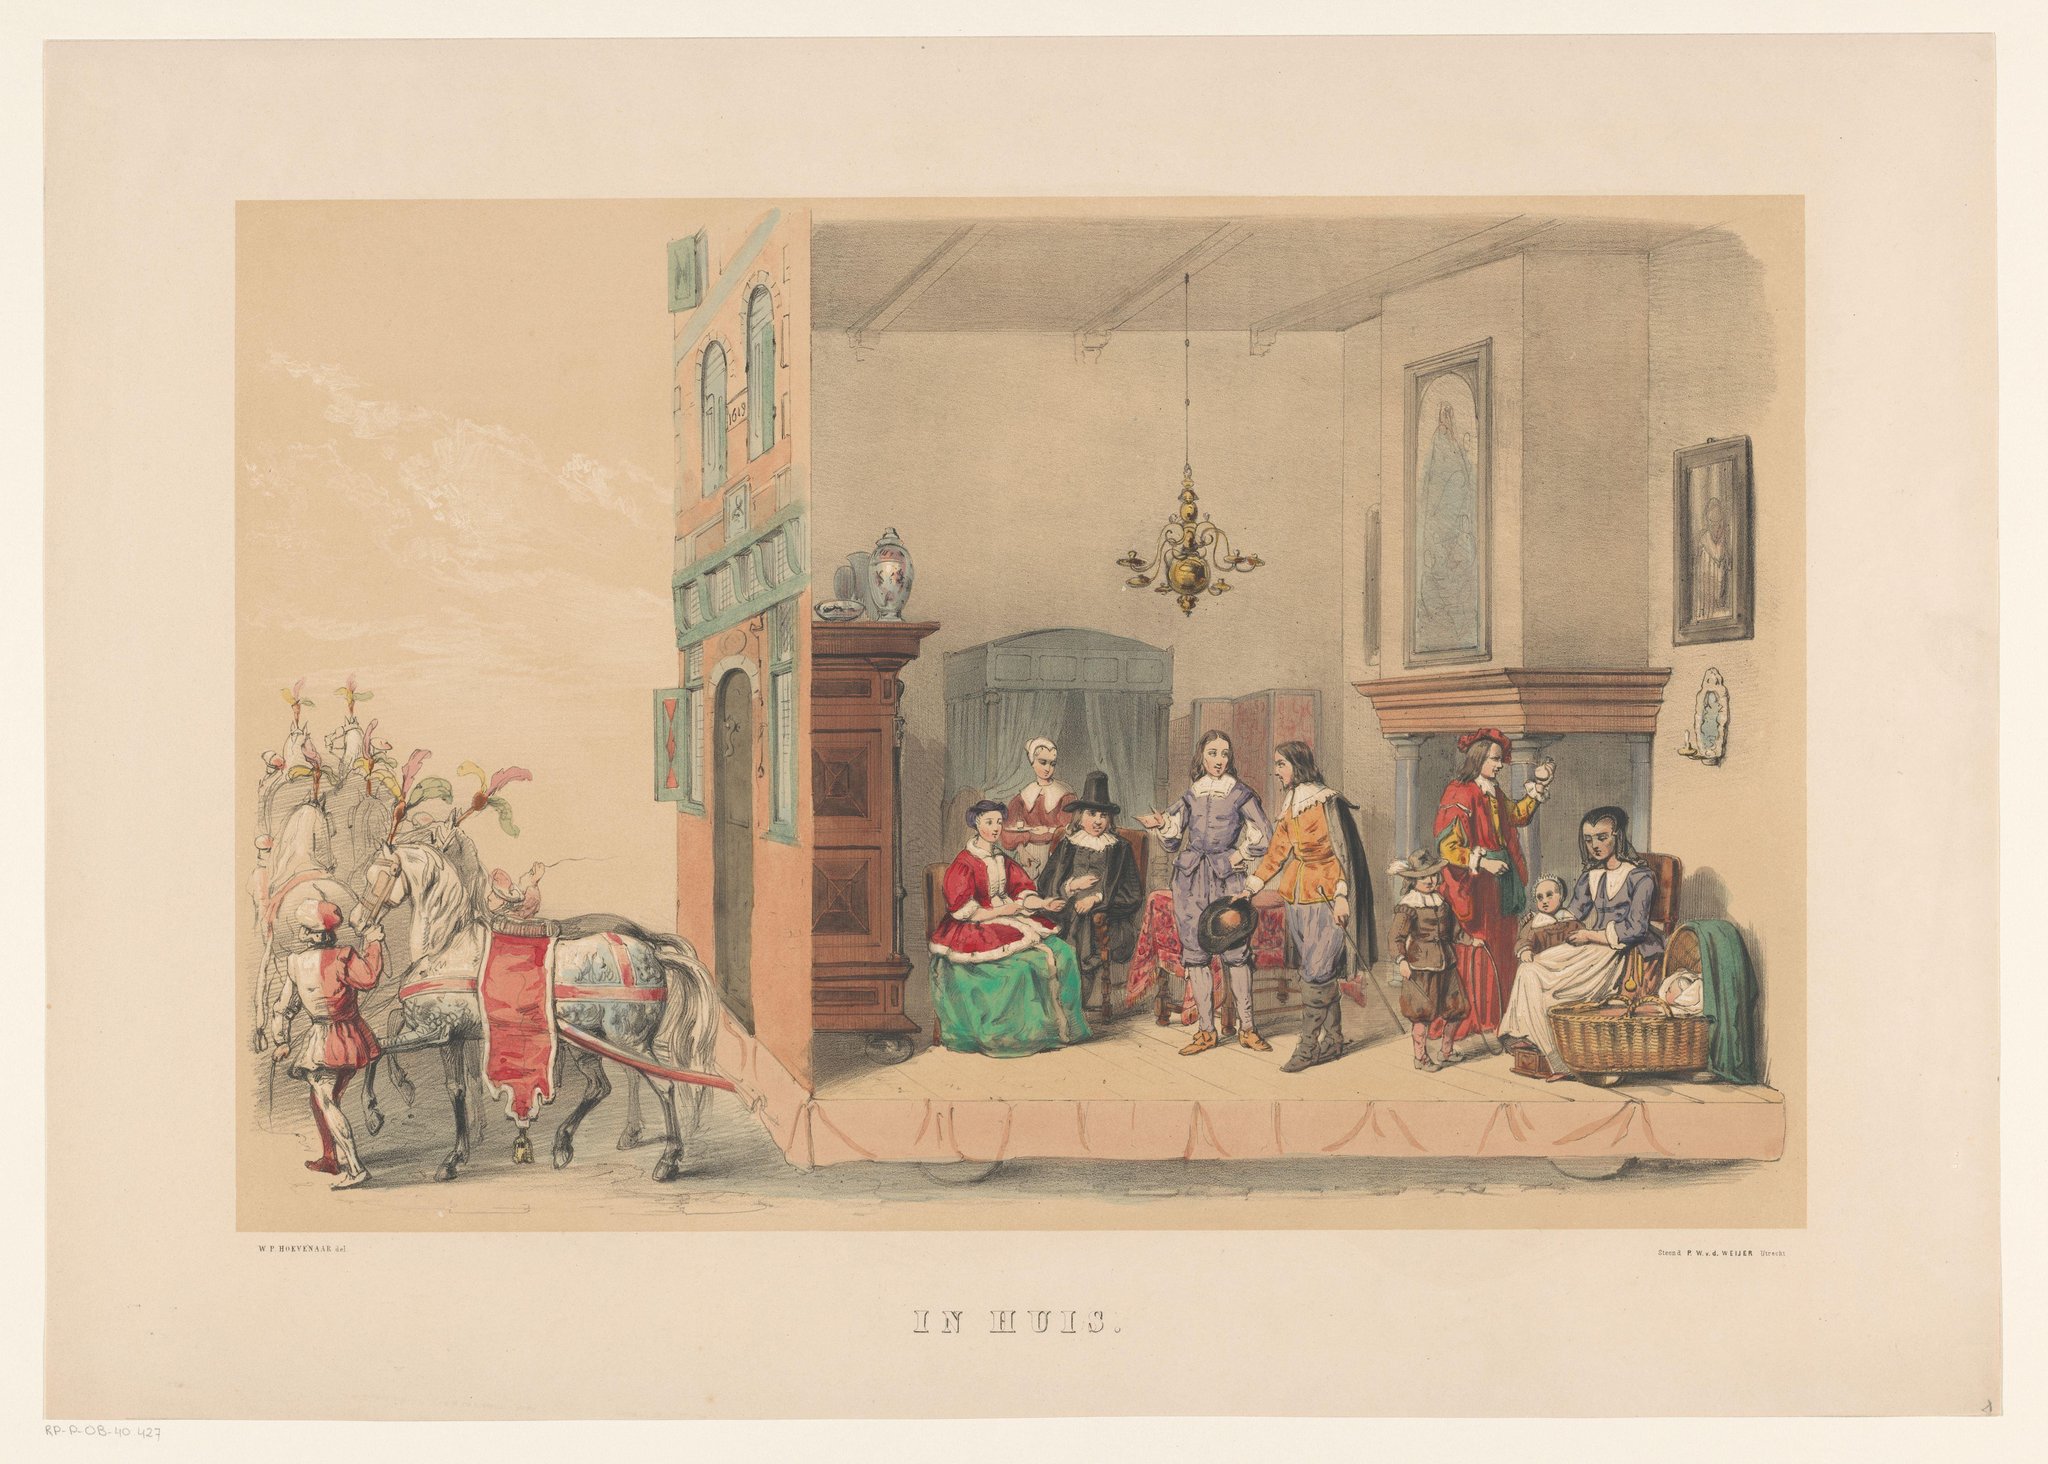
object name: print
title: In huis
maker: pieter wilhelmus van de weijer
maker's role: print maker, printer, publisher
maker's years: 1816-1880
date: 1856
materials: paper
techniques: hand coloring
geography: utrecht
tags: students' pageant, costumes used in pageants, utrecht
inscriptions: collector's mark: Lugt 2228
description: Een praalwagen getrokken door paarden met het interieur van een Nederlands huis en zijn bewoners. Onderdeel van de historische optocht in maskerade opgevoerd door de studenten van de vereniging Mutua Fides van de Utrechtse Hogeschool op 25 juni 1856 ter gelegenheid van de viering van haar 220-jarige bestaan.